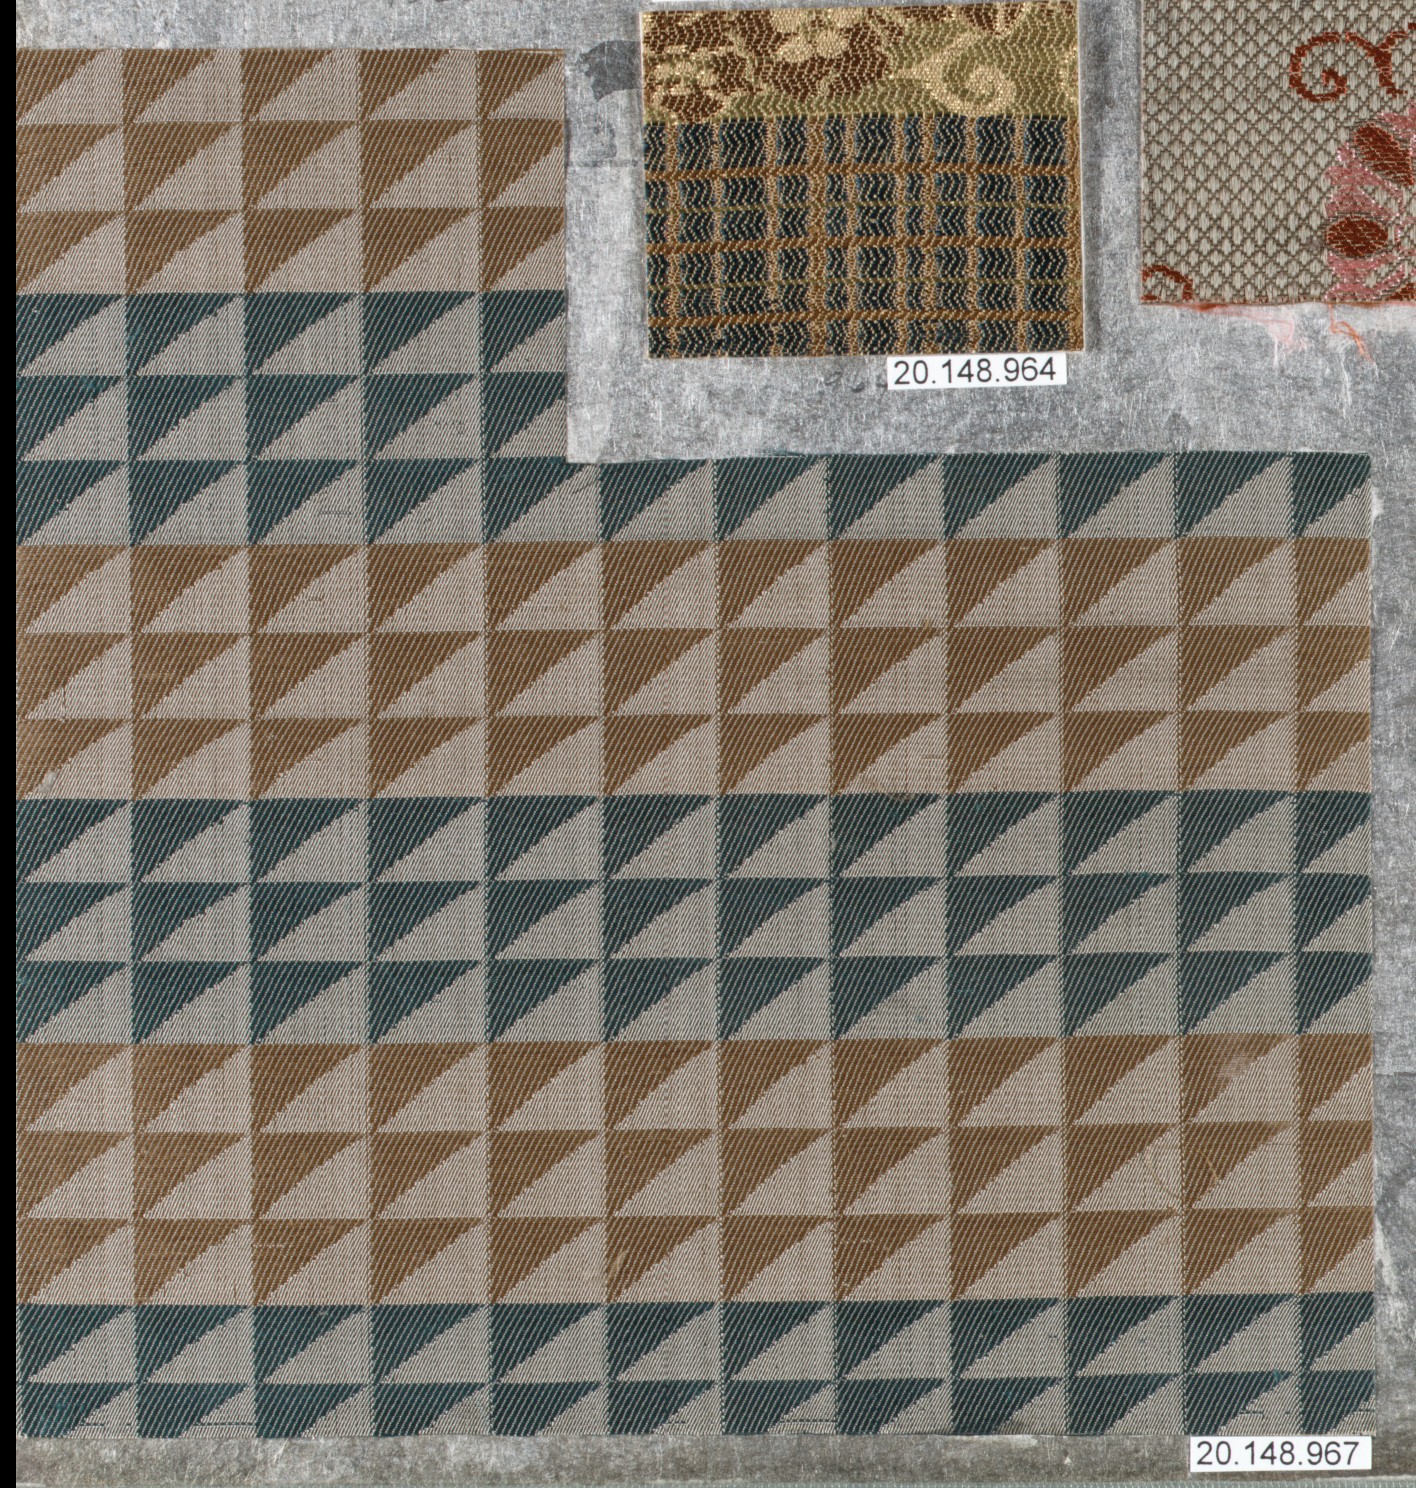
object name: piece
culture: japanese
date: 1701-1800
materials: silk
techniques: compound weave